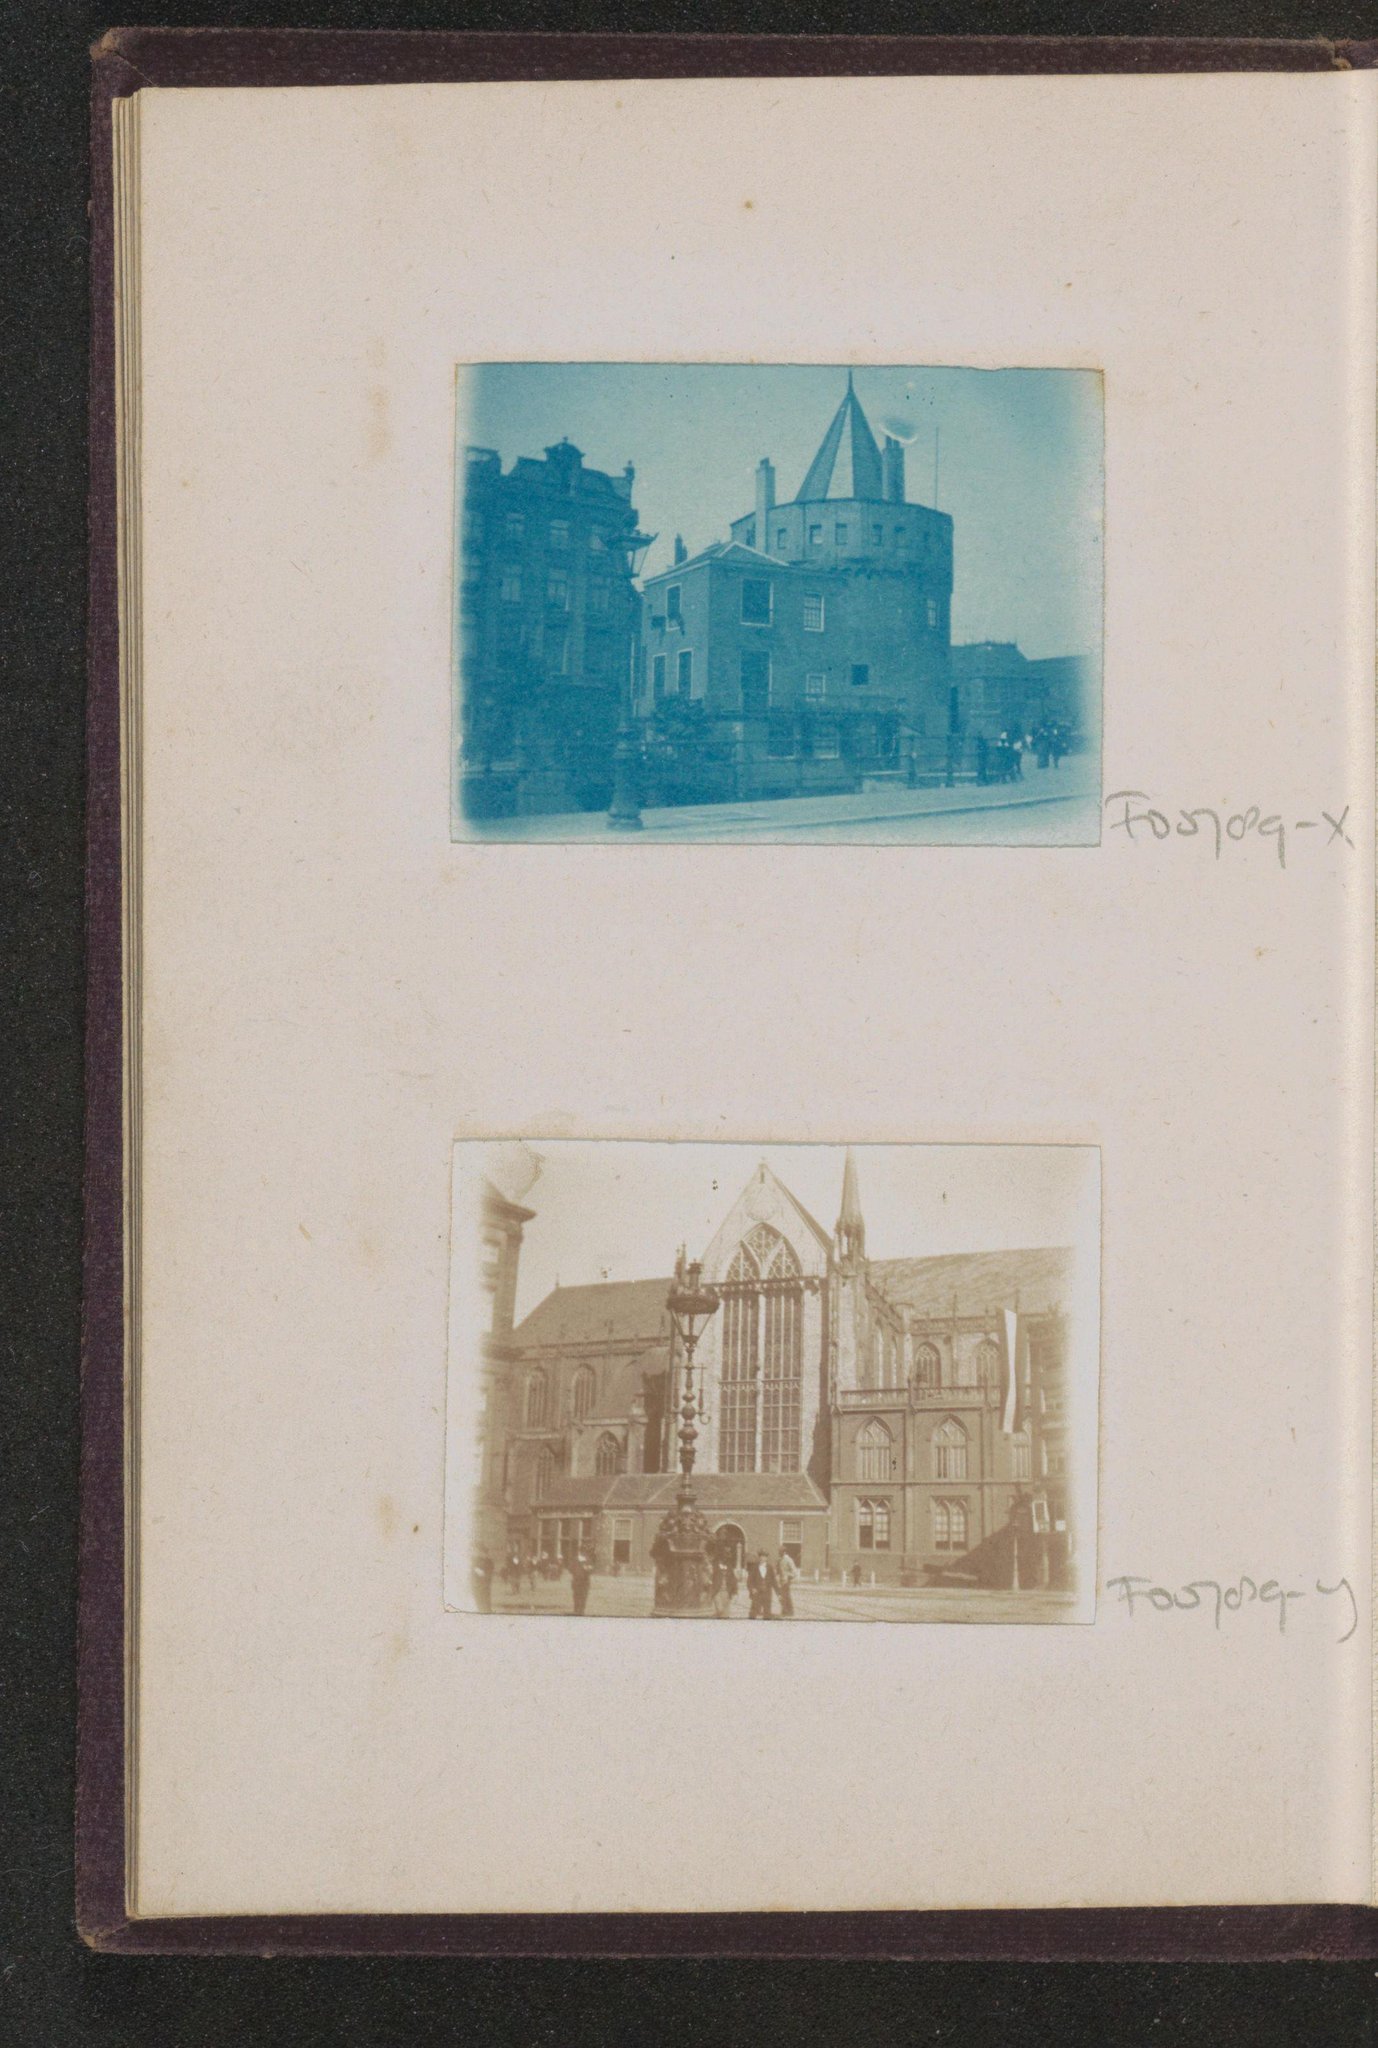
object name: contact print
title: Schreierstoren gezien vanaf de Geldersekade in Amsterdam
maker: Anonymous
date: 1890-1905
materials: paper, photographic support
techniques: cyanotype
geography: amsterdam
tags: towers ~ fortified city, amsterdam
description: Onderdeel van Fotoalbum met 35 foto's van Amsterdam, personen en dieren.